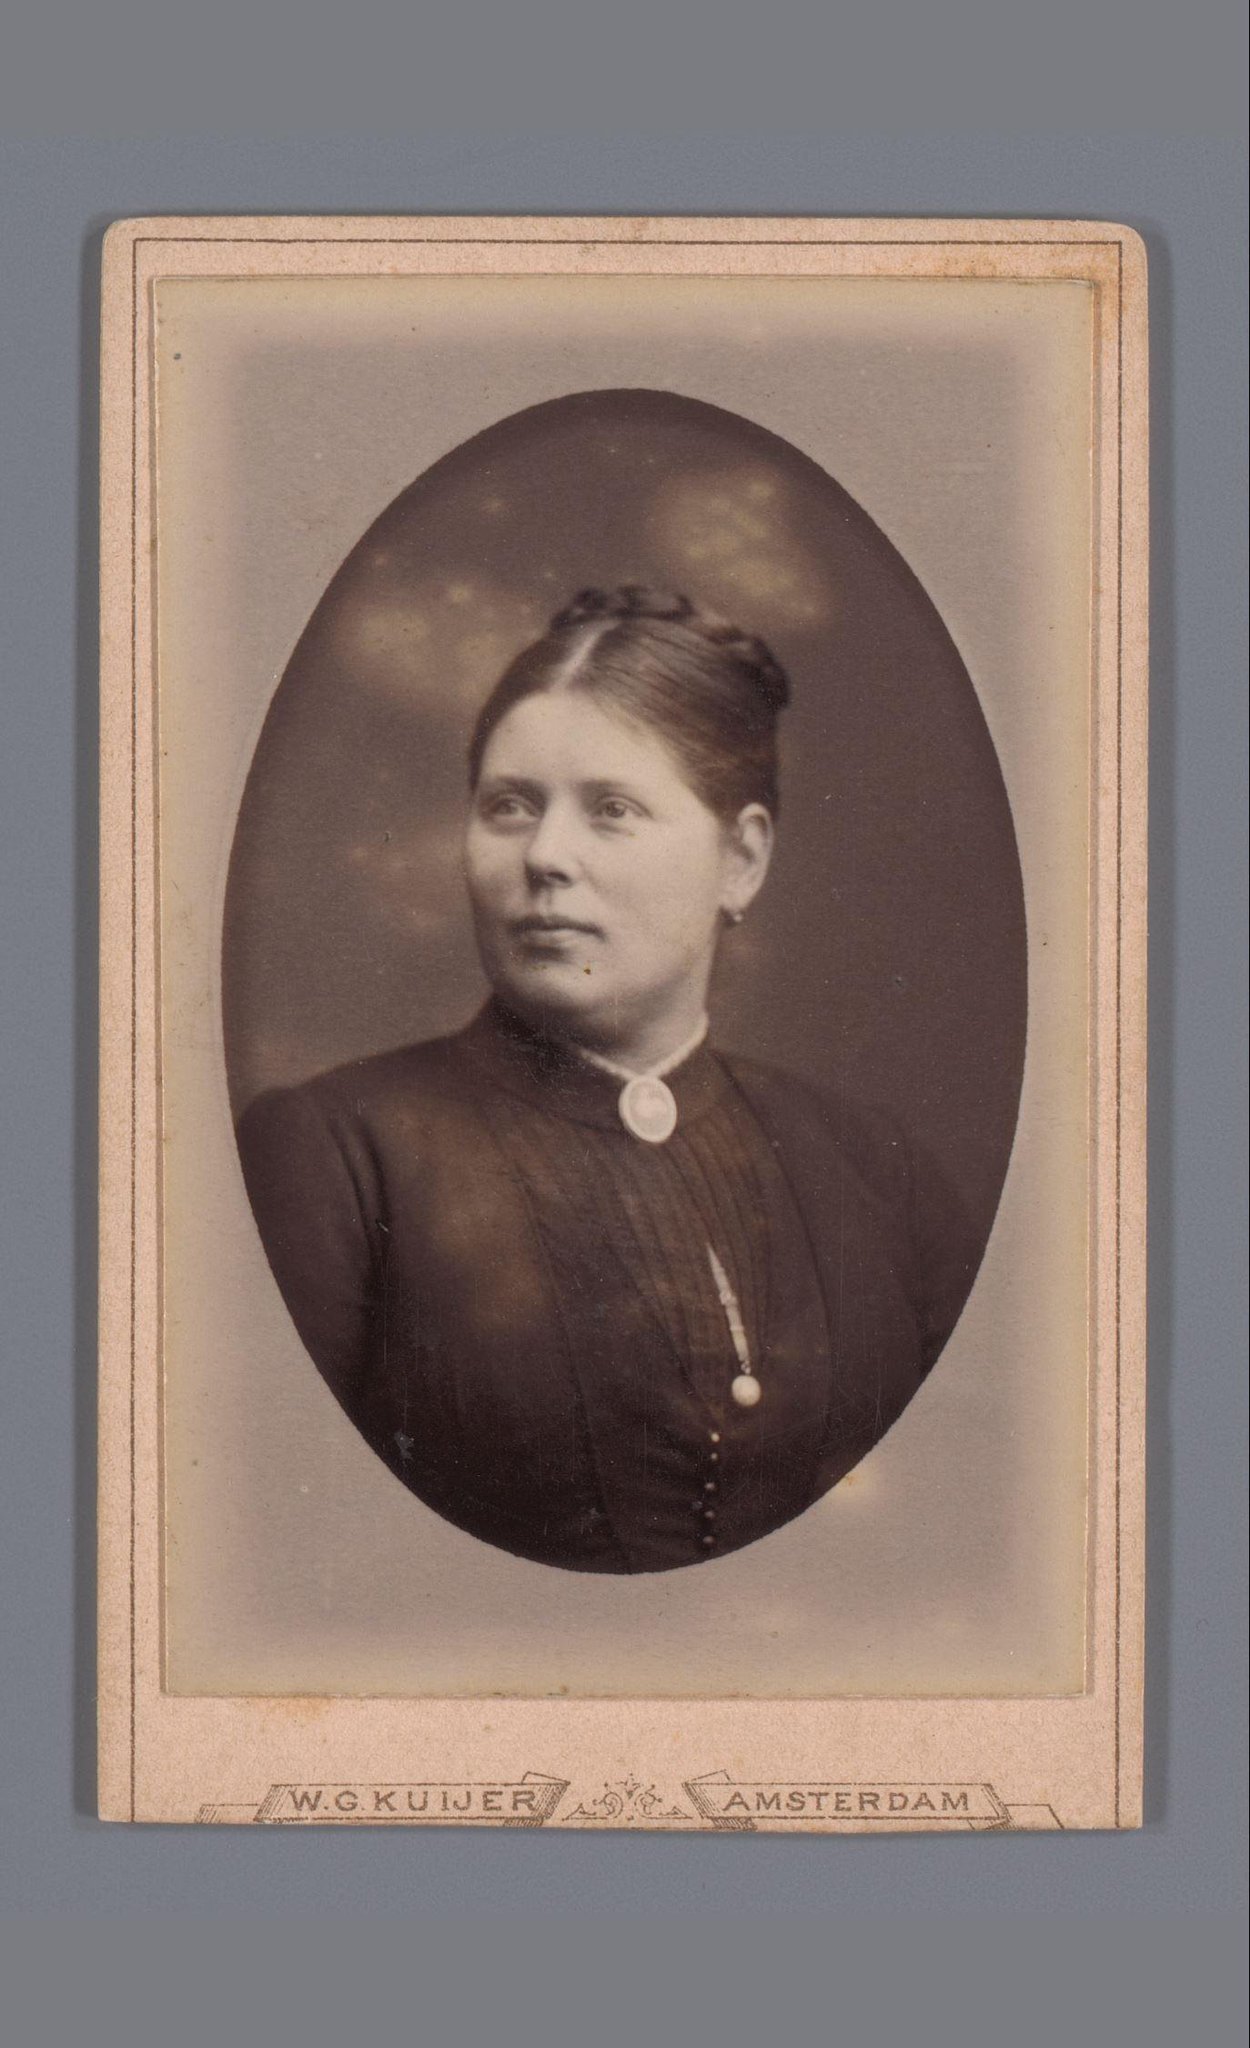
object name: photograph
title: Portret van een onbekende vrouw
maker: willem gerhardus kuijer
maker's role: fotograaf, hoffotograaf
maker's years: 1834-1899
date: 1895-1899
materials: cardboard, photographic support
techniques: collodion silver print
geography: amsterdam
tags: historical persons - bb - woman, amsterdam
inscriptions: workshop stamp: ‘W.G. Kuijer/ Amsterdam, Westermarkt 19’